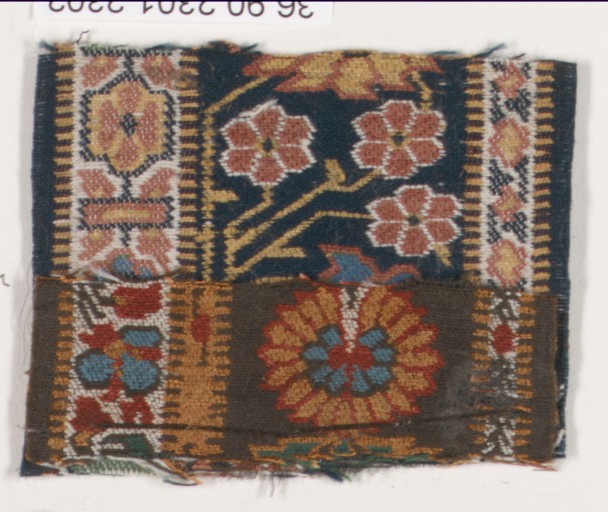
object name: border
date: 1801-1900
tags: flowers